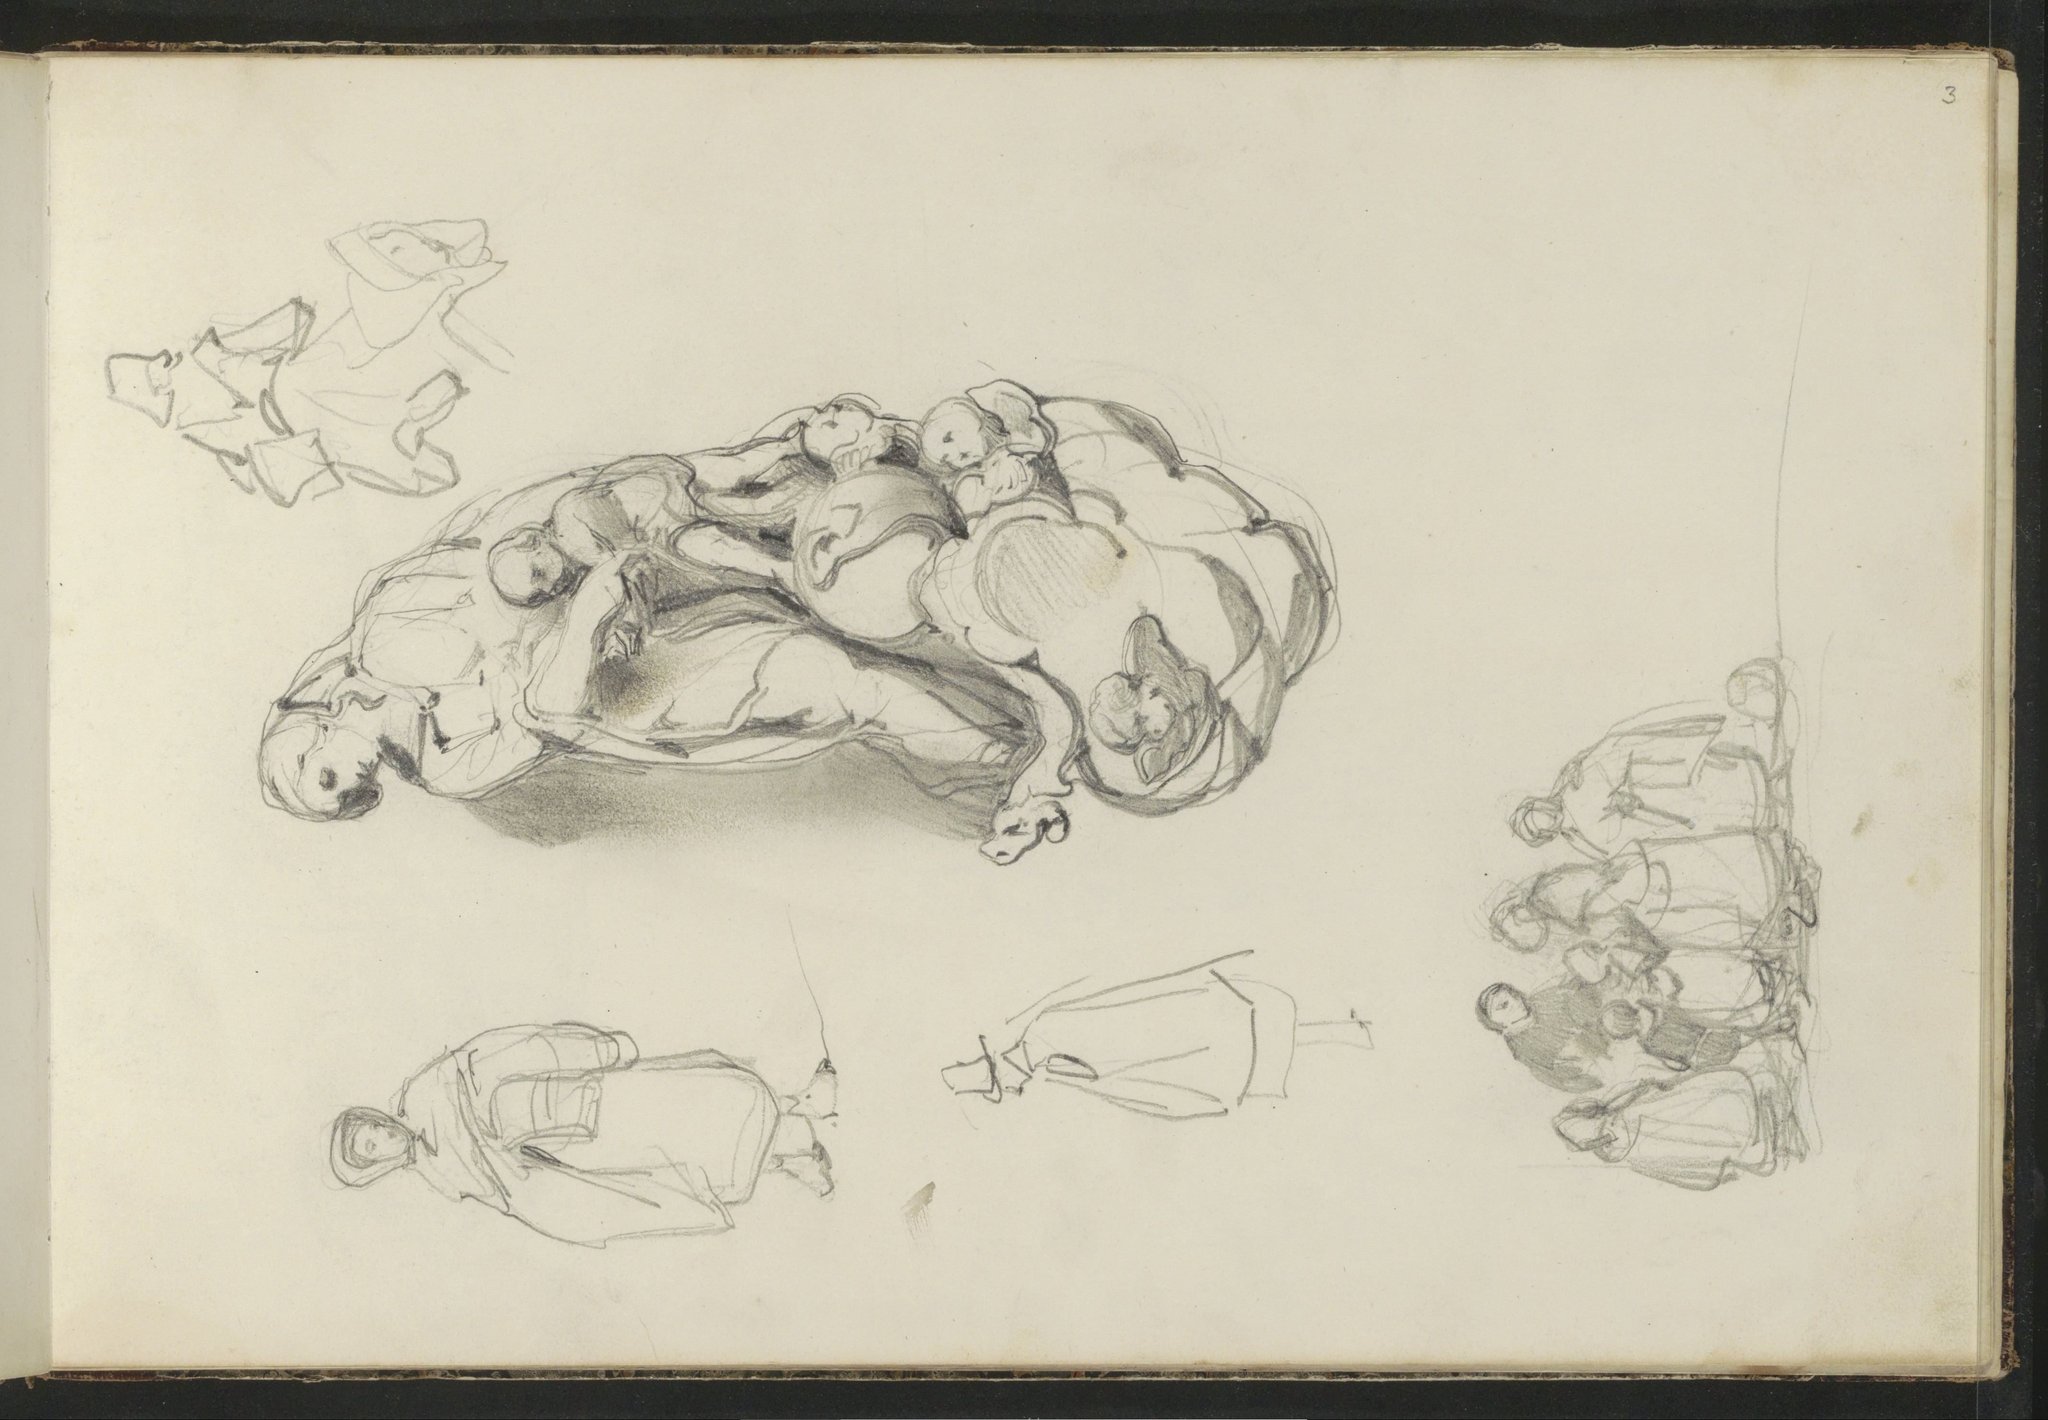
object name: sketchbook leaf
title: Maria en het Christuskind op een wereldbol omgeven door engelen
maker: johannes bosboom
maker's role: draughtsman, painter, print maker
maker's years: 1817-1891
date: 1827-1891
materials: paper, pencil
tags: standing figure, madonna: mary (standing) with the christ-child free-standing (or leaning against her) (+ angel(s))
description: Vermoedelijk gekopieerd naar een schilderij of beeldhouwwerk. Teven figuurstudies. Blad 3 recto uit een schetsboek met 11 bladen.